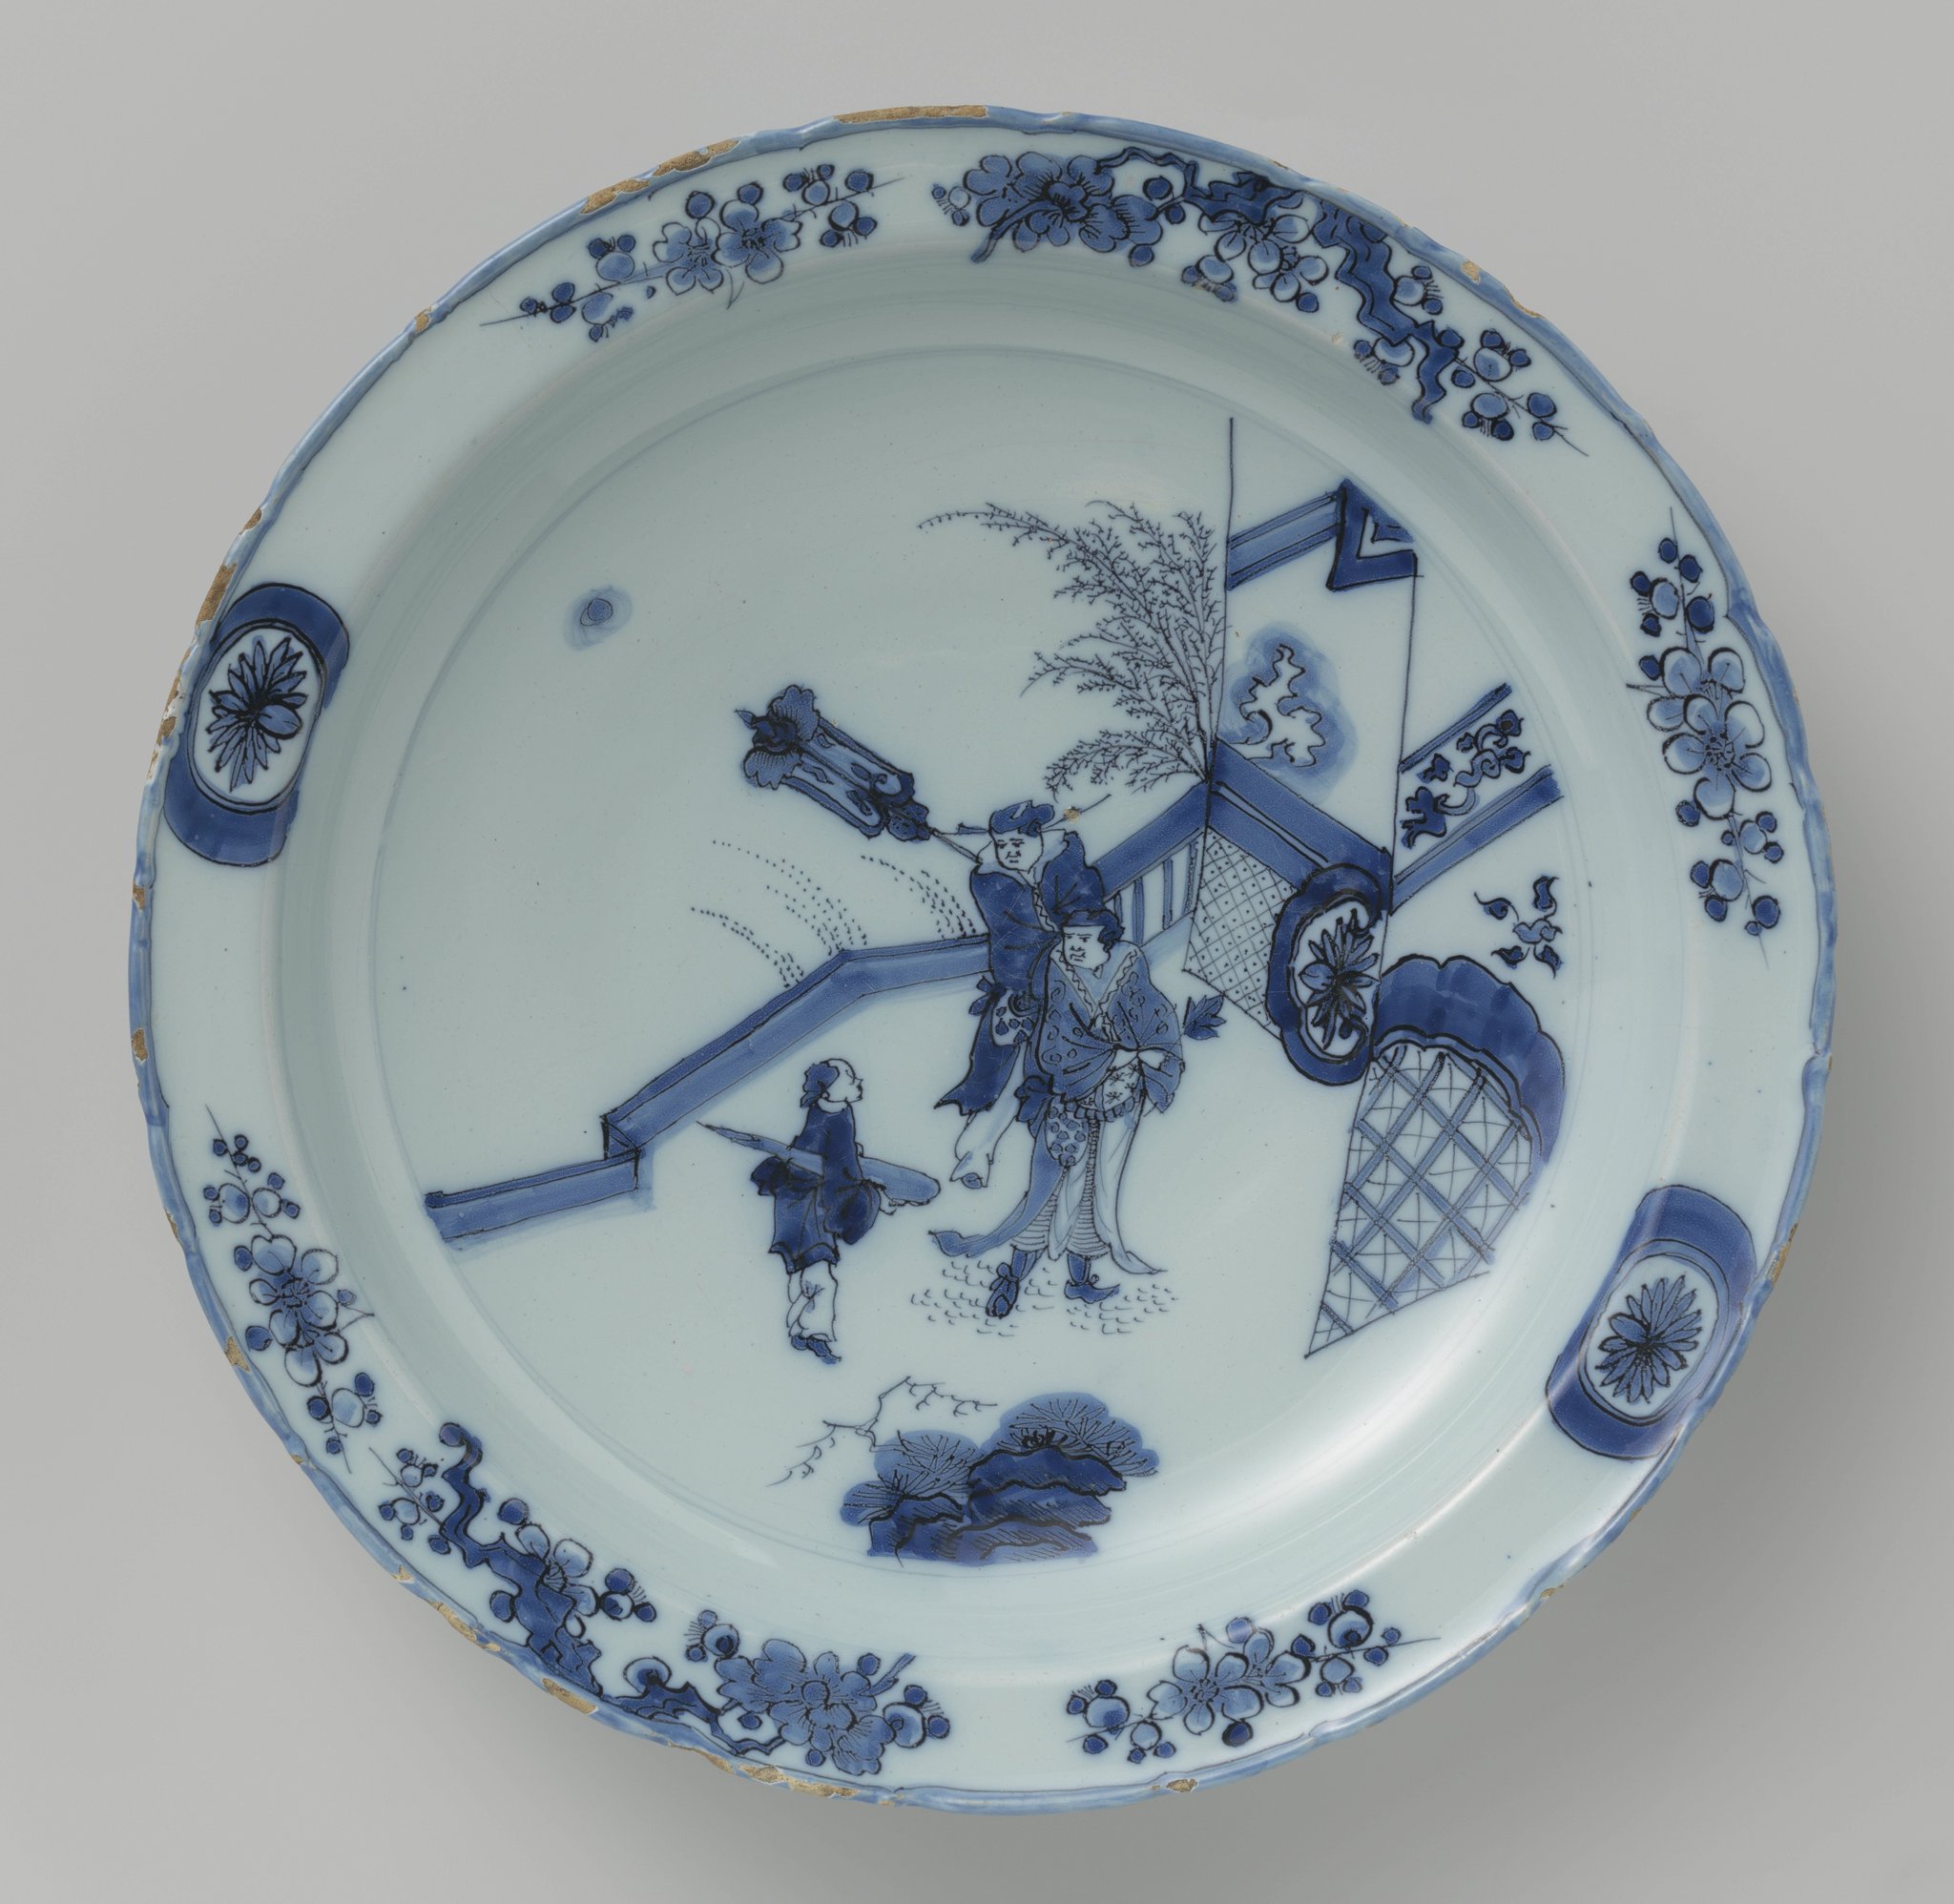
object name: platter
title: Dish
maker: lambertus cleffius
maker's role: ceramicist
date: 1680-1690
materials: earthenware, glaze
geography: delft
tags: chinese (+ other cultural aspects), flowers ~ ornament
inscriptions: mark: ‘CL (ineen)’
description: This dish stands out not so much for its decorations, but rather the empty spaces between them. The painter boldly left large areas of the plate unpainted, which was rarely done in Delft. Precisely because of this emptiness and because the scene is off-centre, this plate has a decidedly Asian appearance.